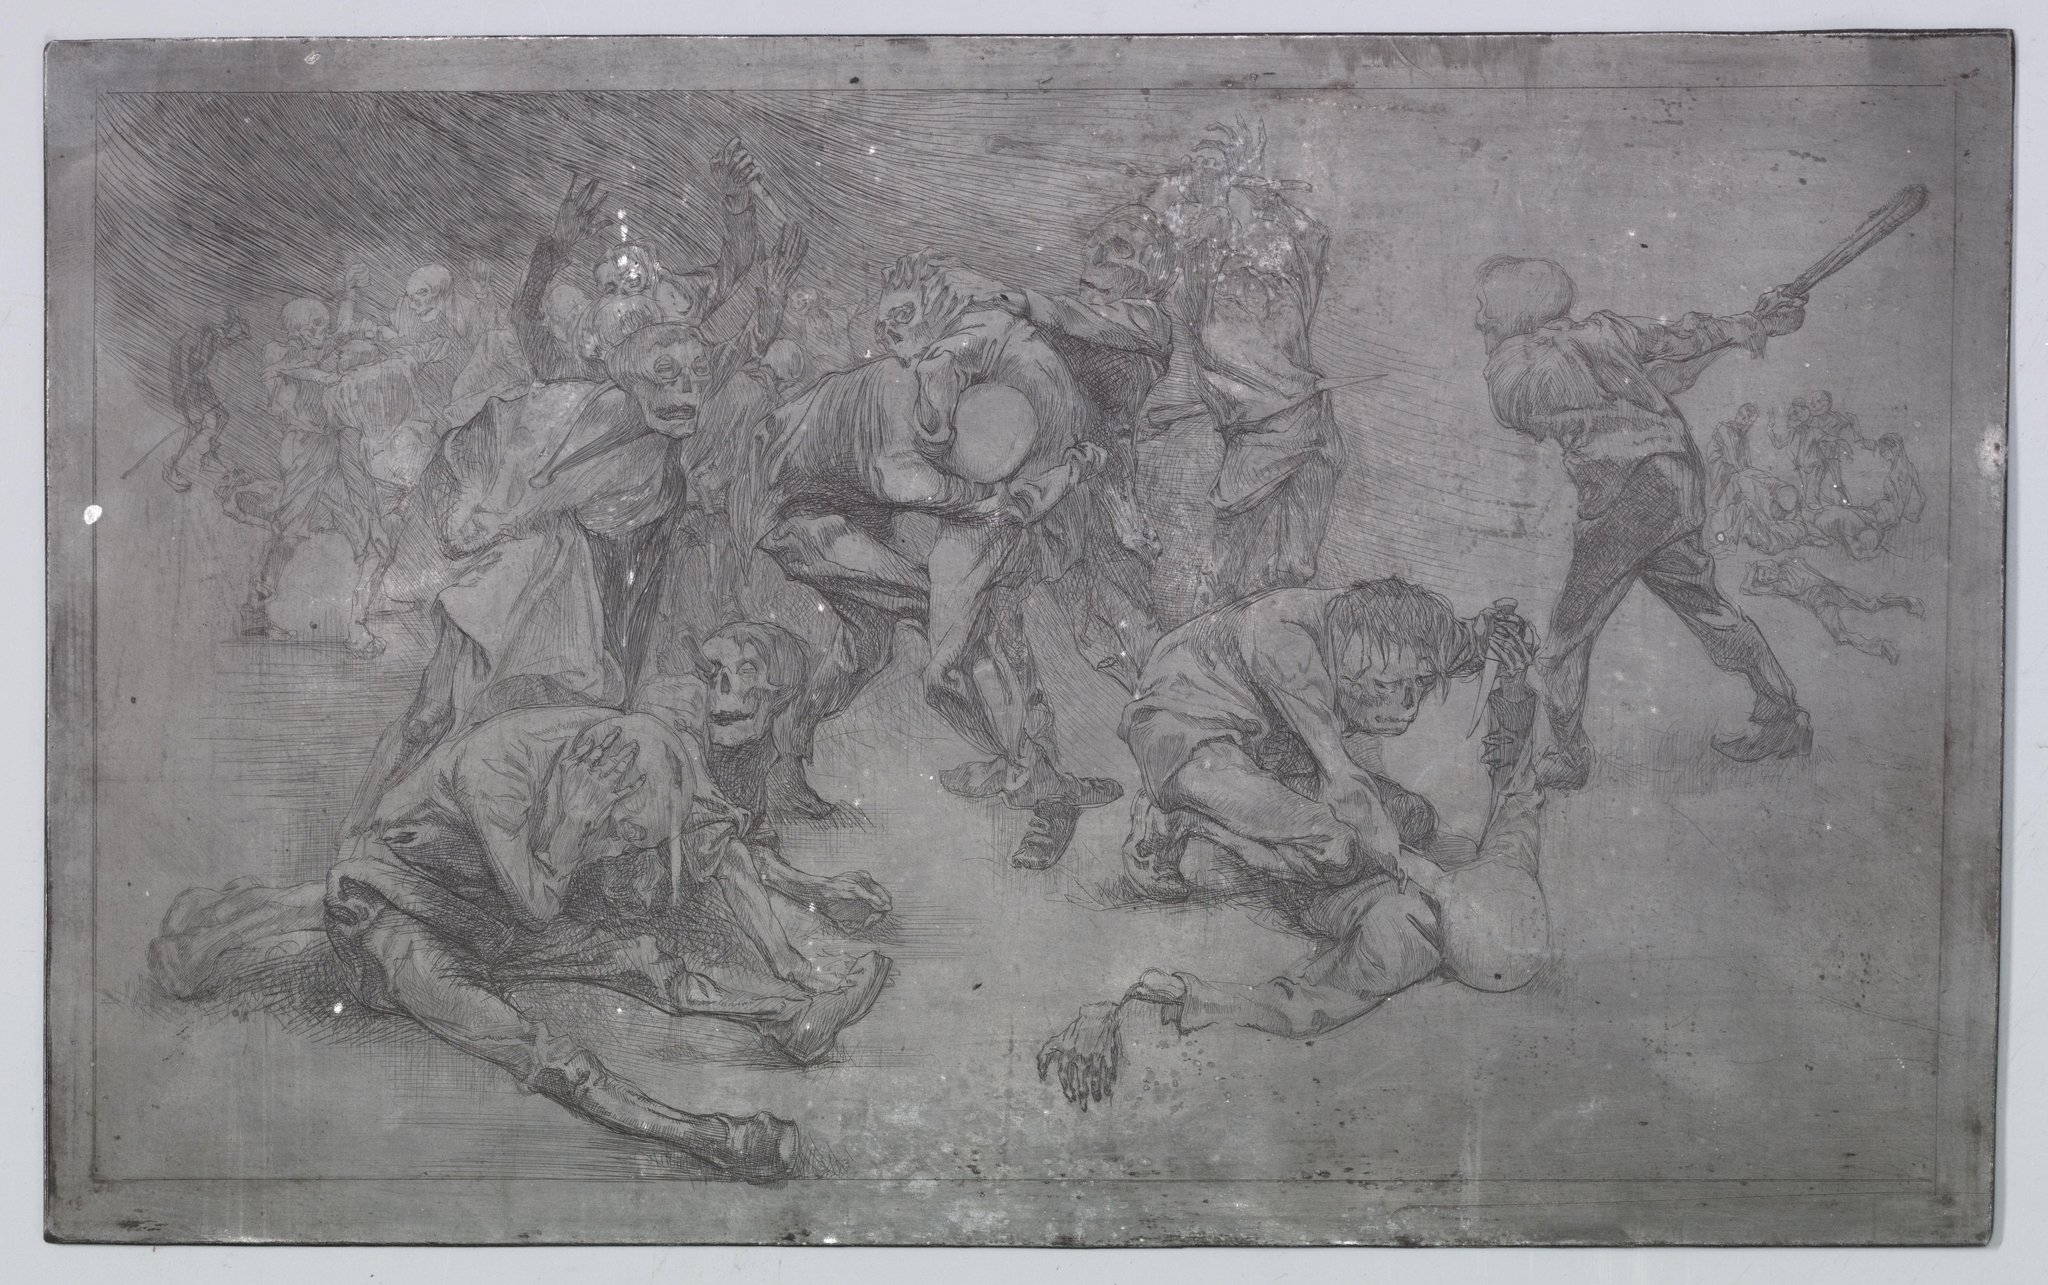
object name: zinkplaat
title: Vechtende mensen met doodshoofden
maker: johannes josephus aarts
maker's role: draughtsman, print maker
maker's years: 1871-1934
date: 1881-1934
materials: zinc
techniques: etching